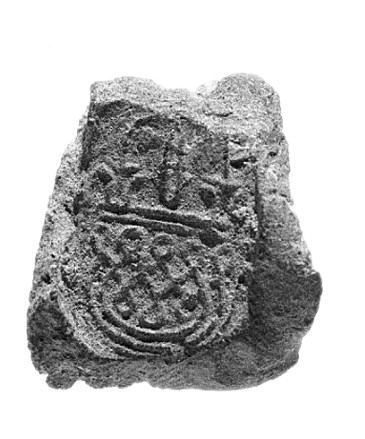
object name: sealing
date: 1981-1640 BCE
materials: mud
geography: egypt